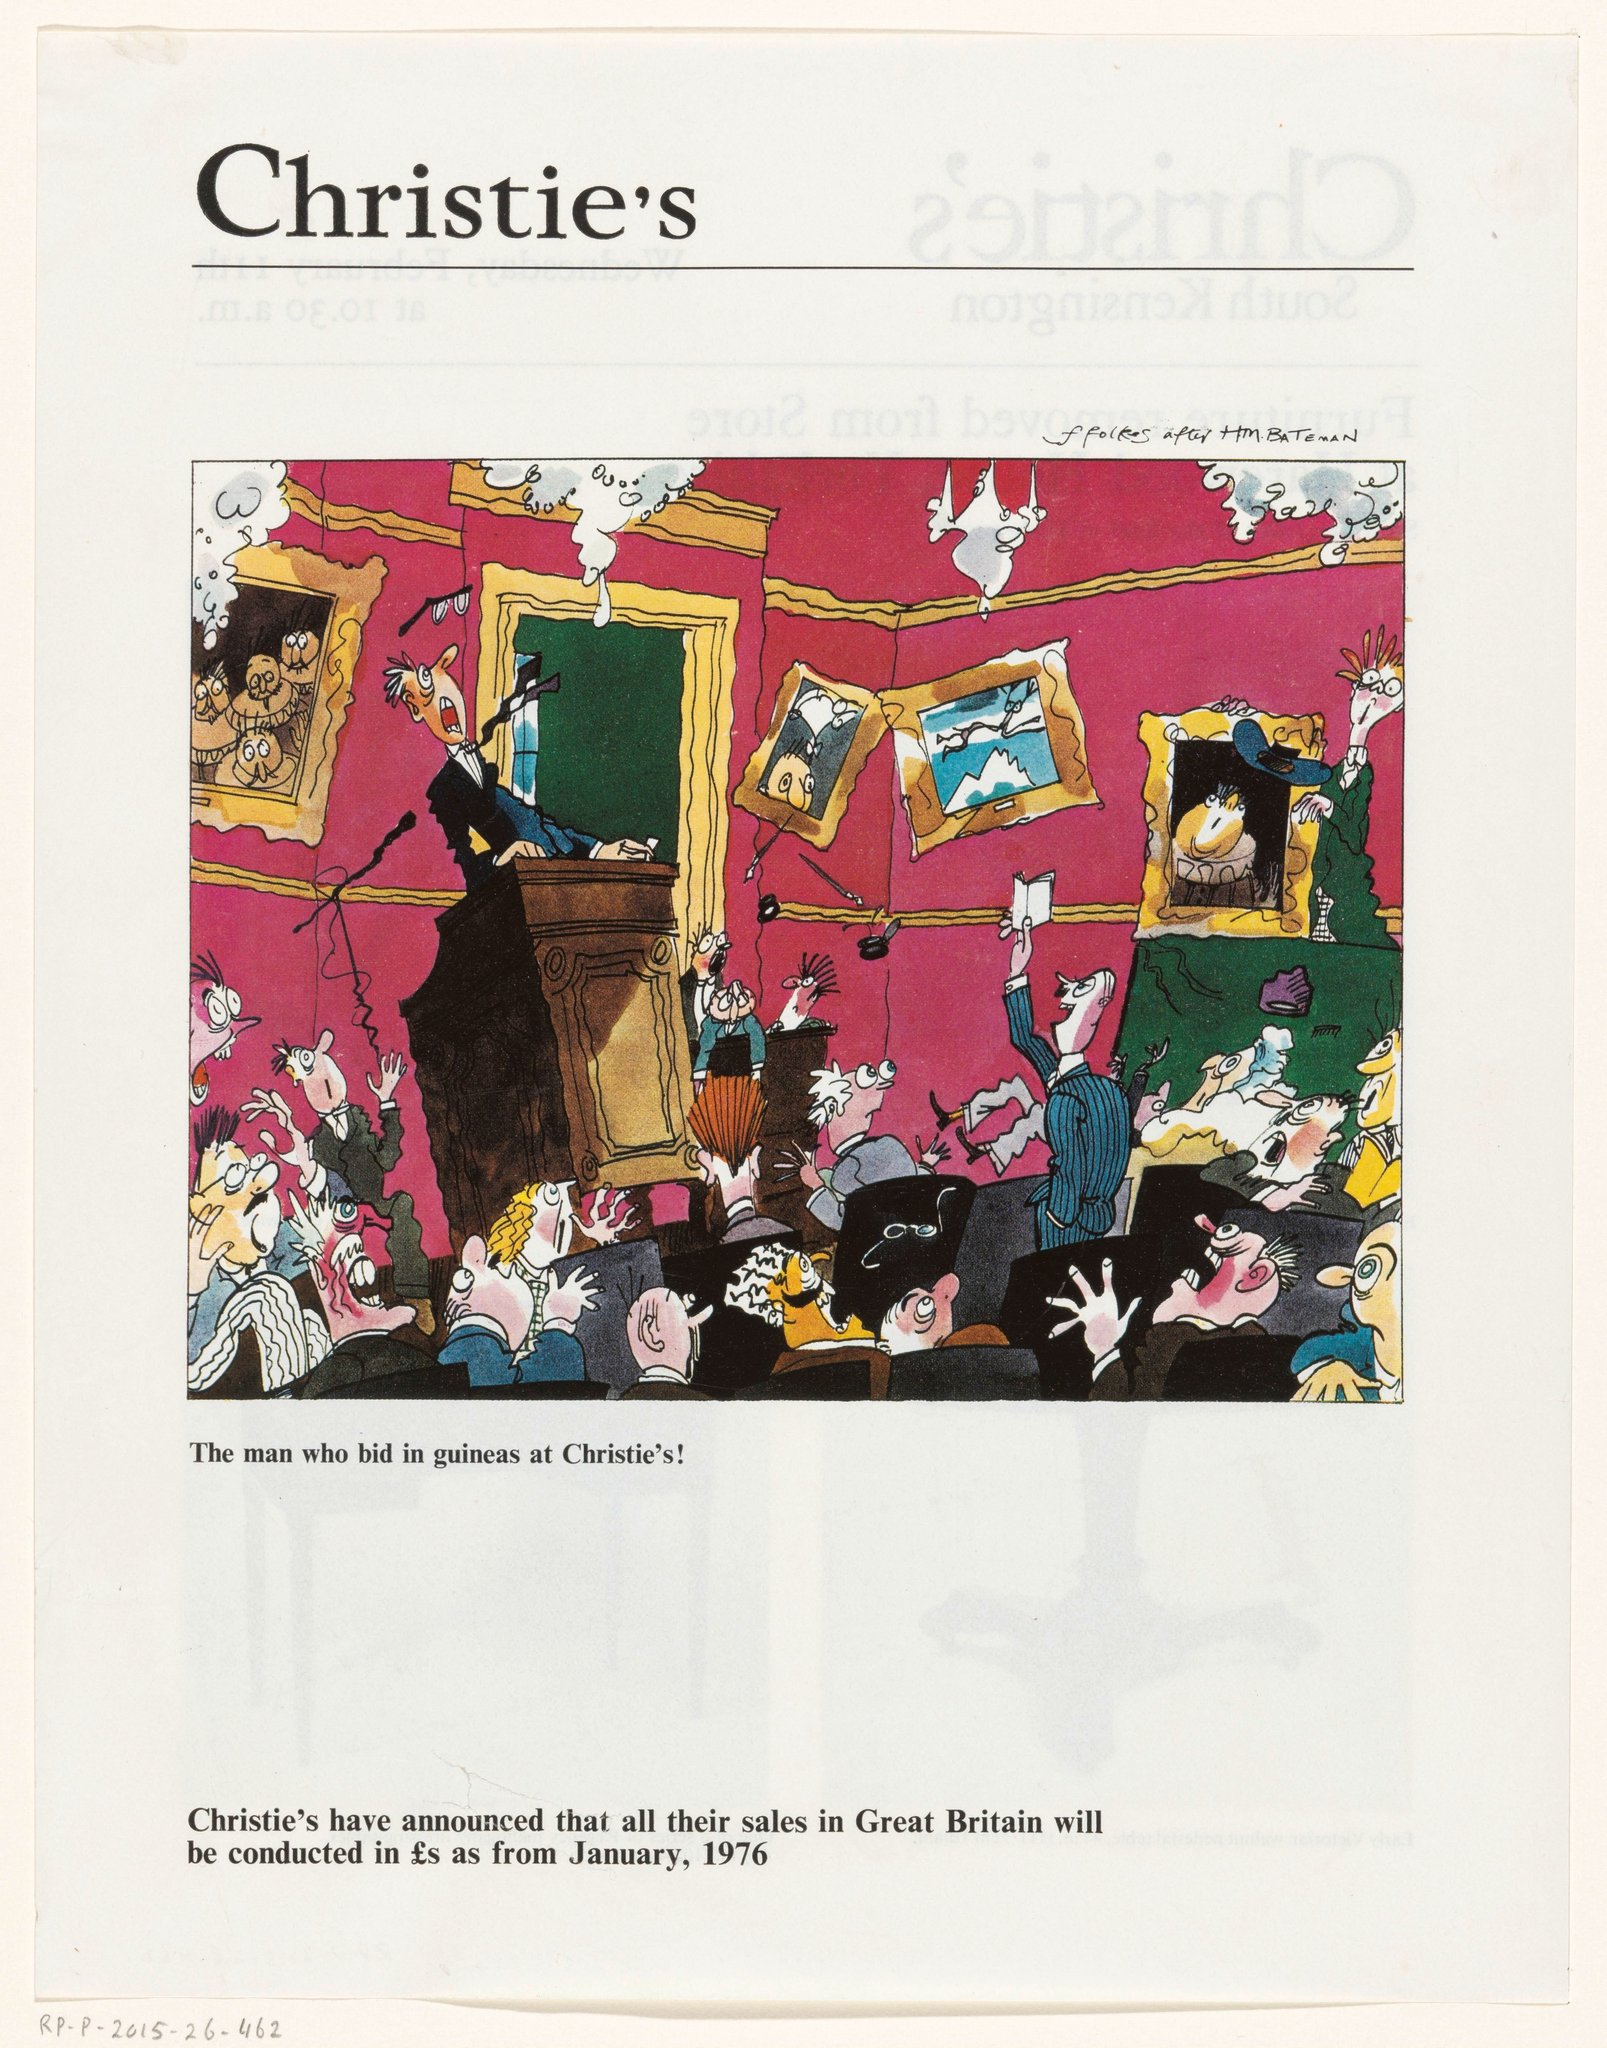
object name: illustration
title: Veiling bij Christie's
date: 1975-1976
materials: paper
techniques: offset printed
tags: art sale, auction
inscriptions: collector's mark: Lugt 2228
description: Veilingzaal waar zojuist, tot schrik van de aanwezigen, een staande man met een notitieboekje een bod in guineas heeft uitgebracht.